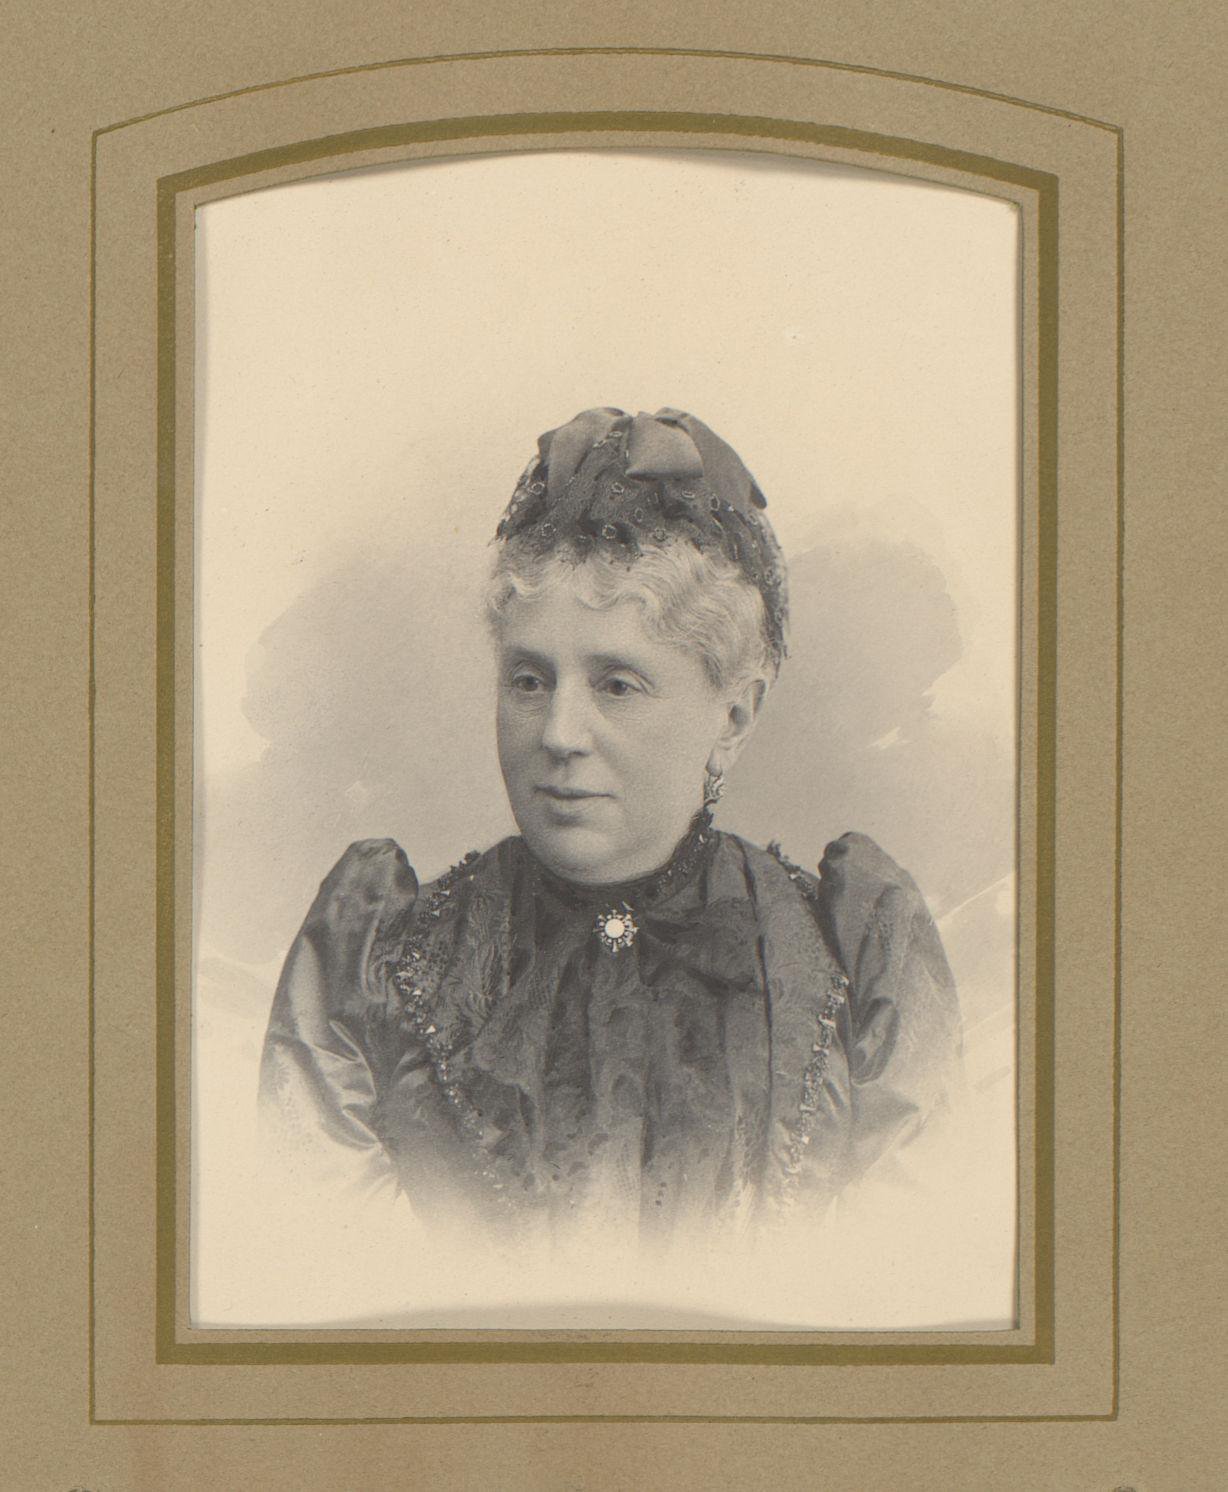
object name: photograph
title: Portret van een vrouw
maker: Anonymous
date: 1883-1914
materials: cardboard, photographic support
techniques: platinum process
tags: historical persons - bb - woman